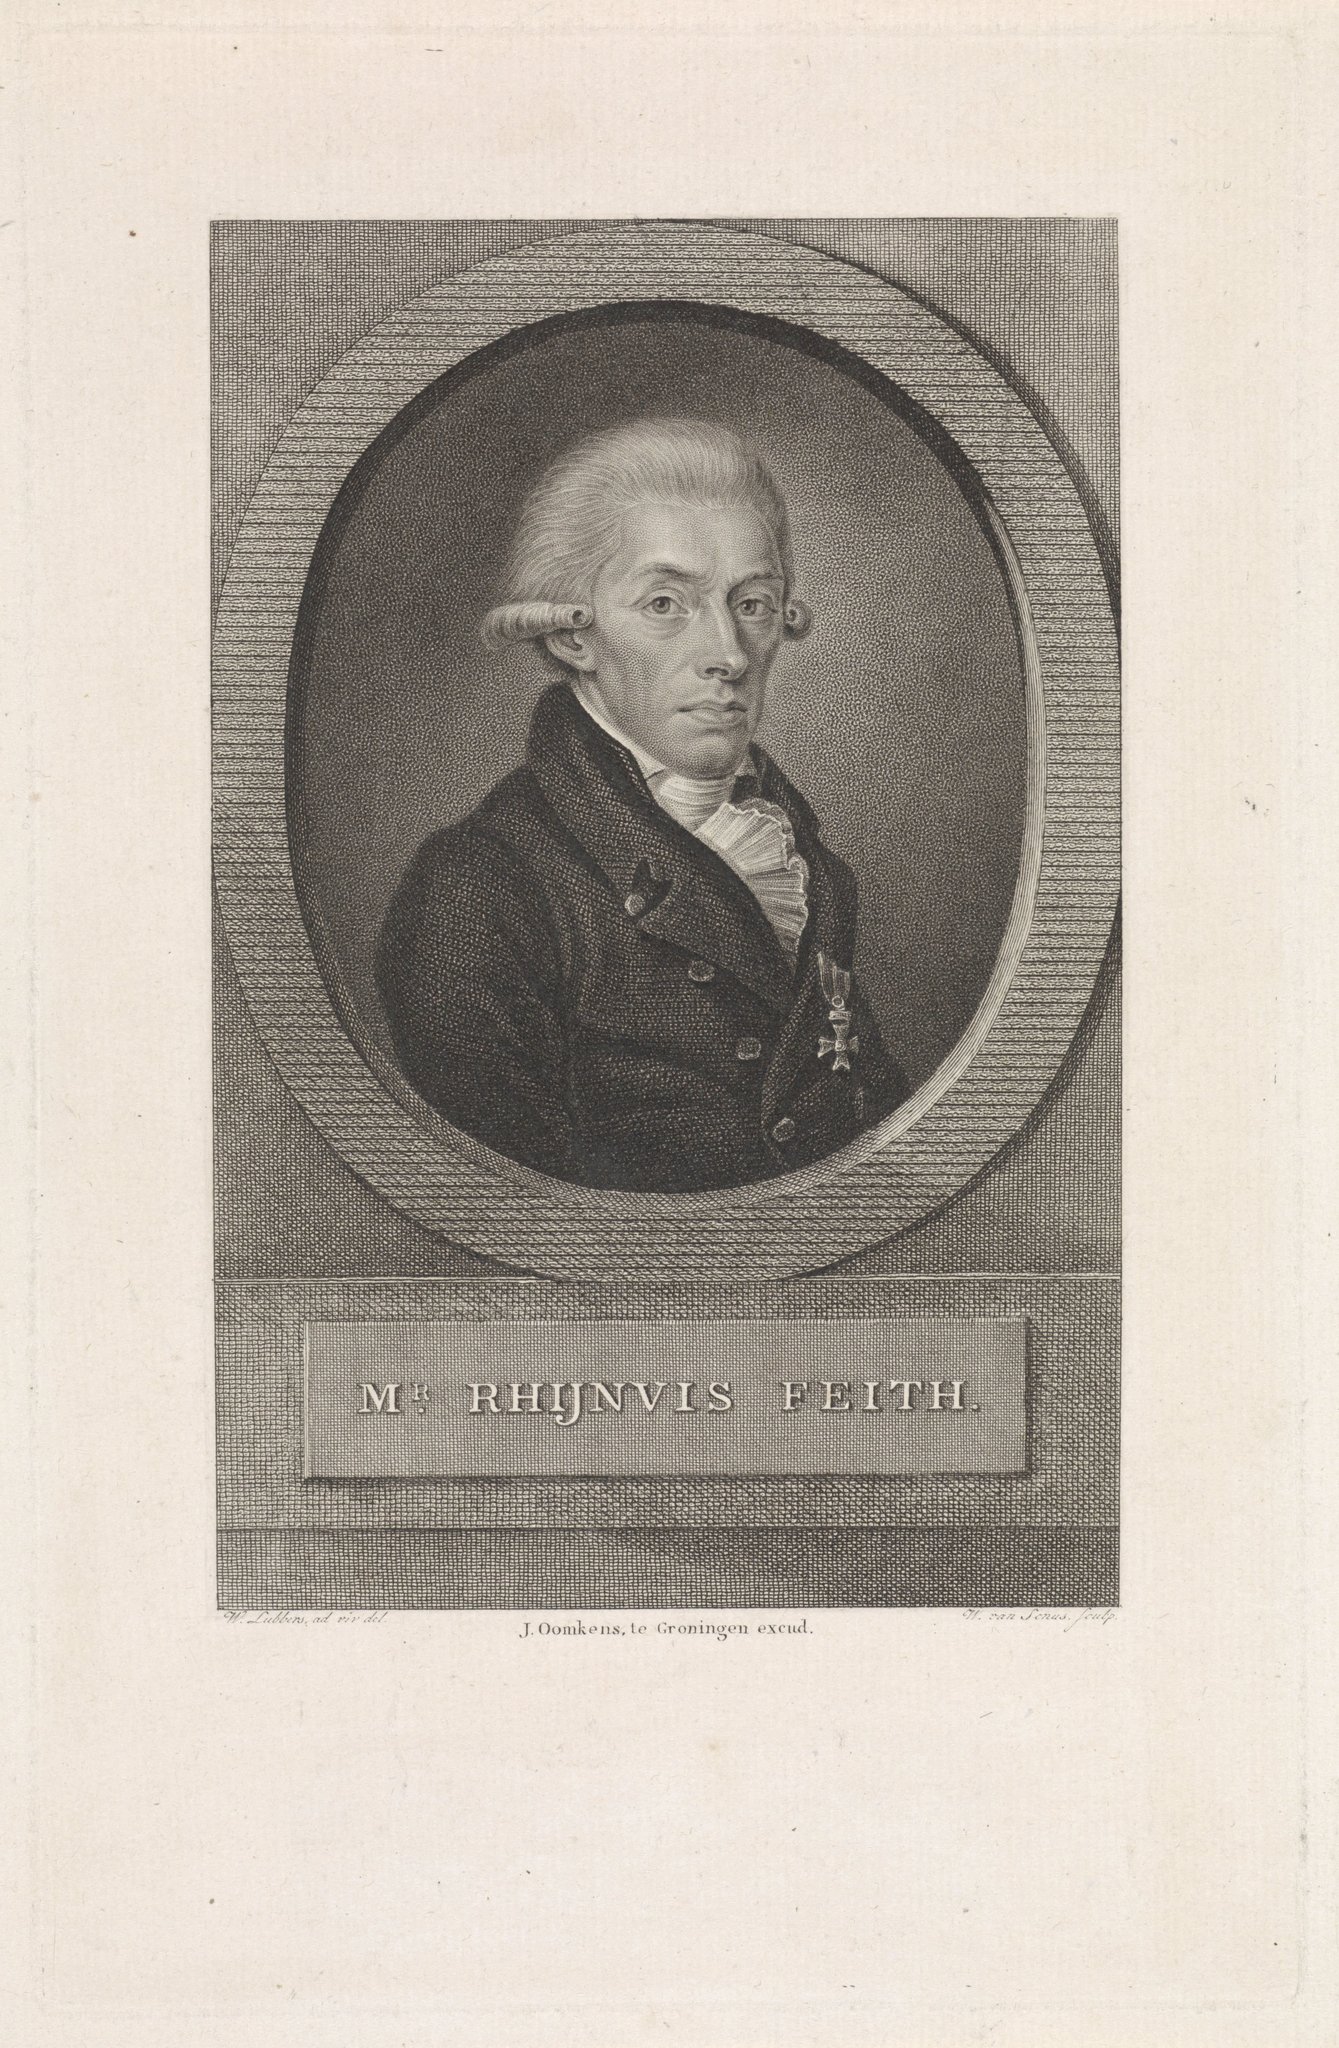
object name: print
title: Portret van Rhijnvis Feith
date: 1783-1844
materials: paper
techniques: engraving, etching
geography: groningen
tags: rhijnvis feith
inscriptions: collector's mark: Lugt 2228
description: Portret van de letterkundige, schrijver en dichter Rhijnvis Feith.